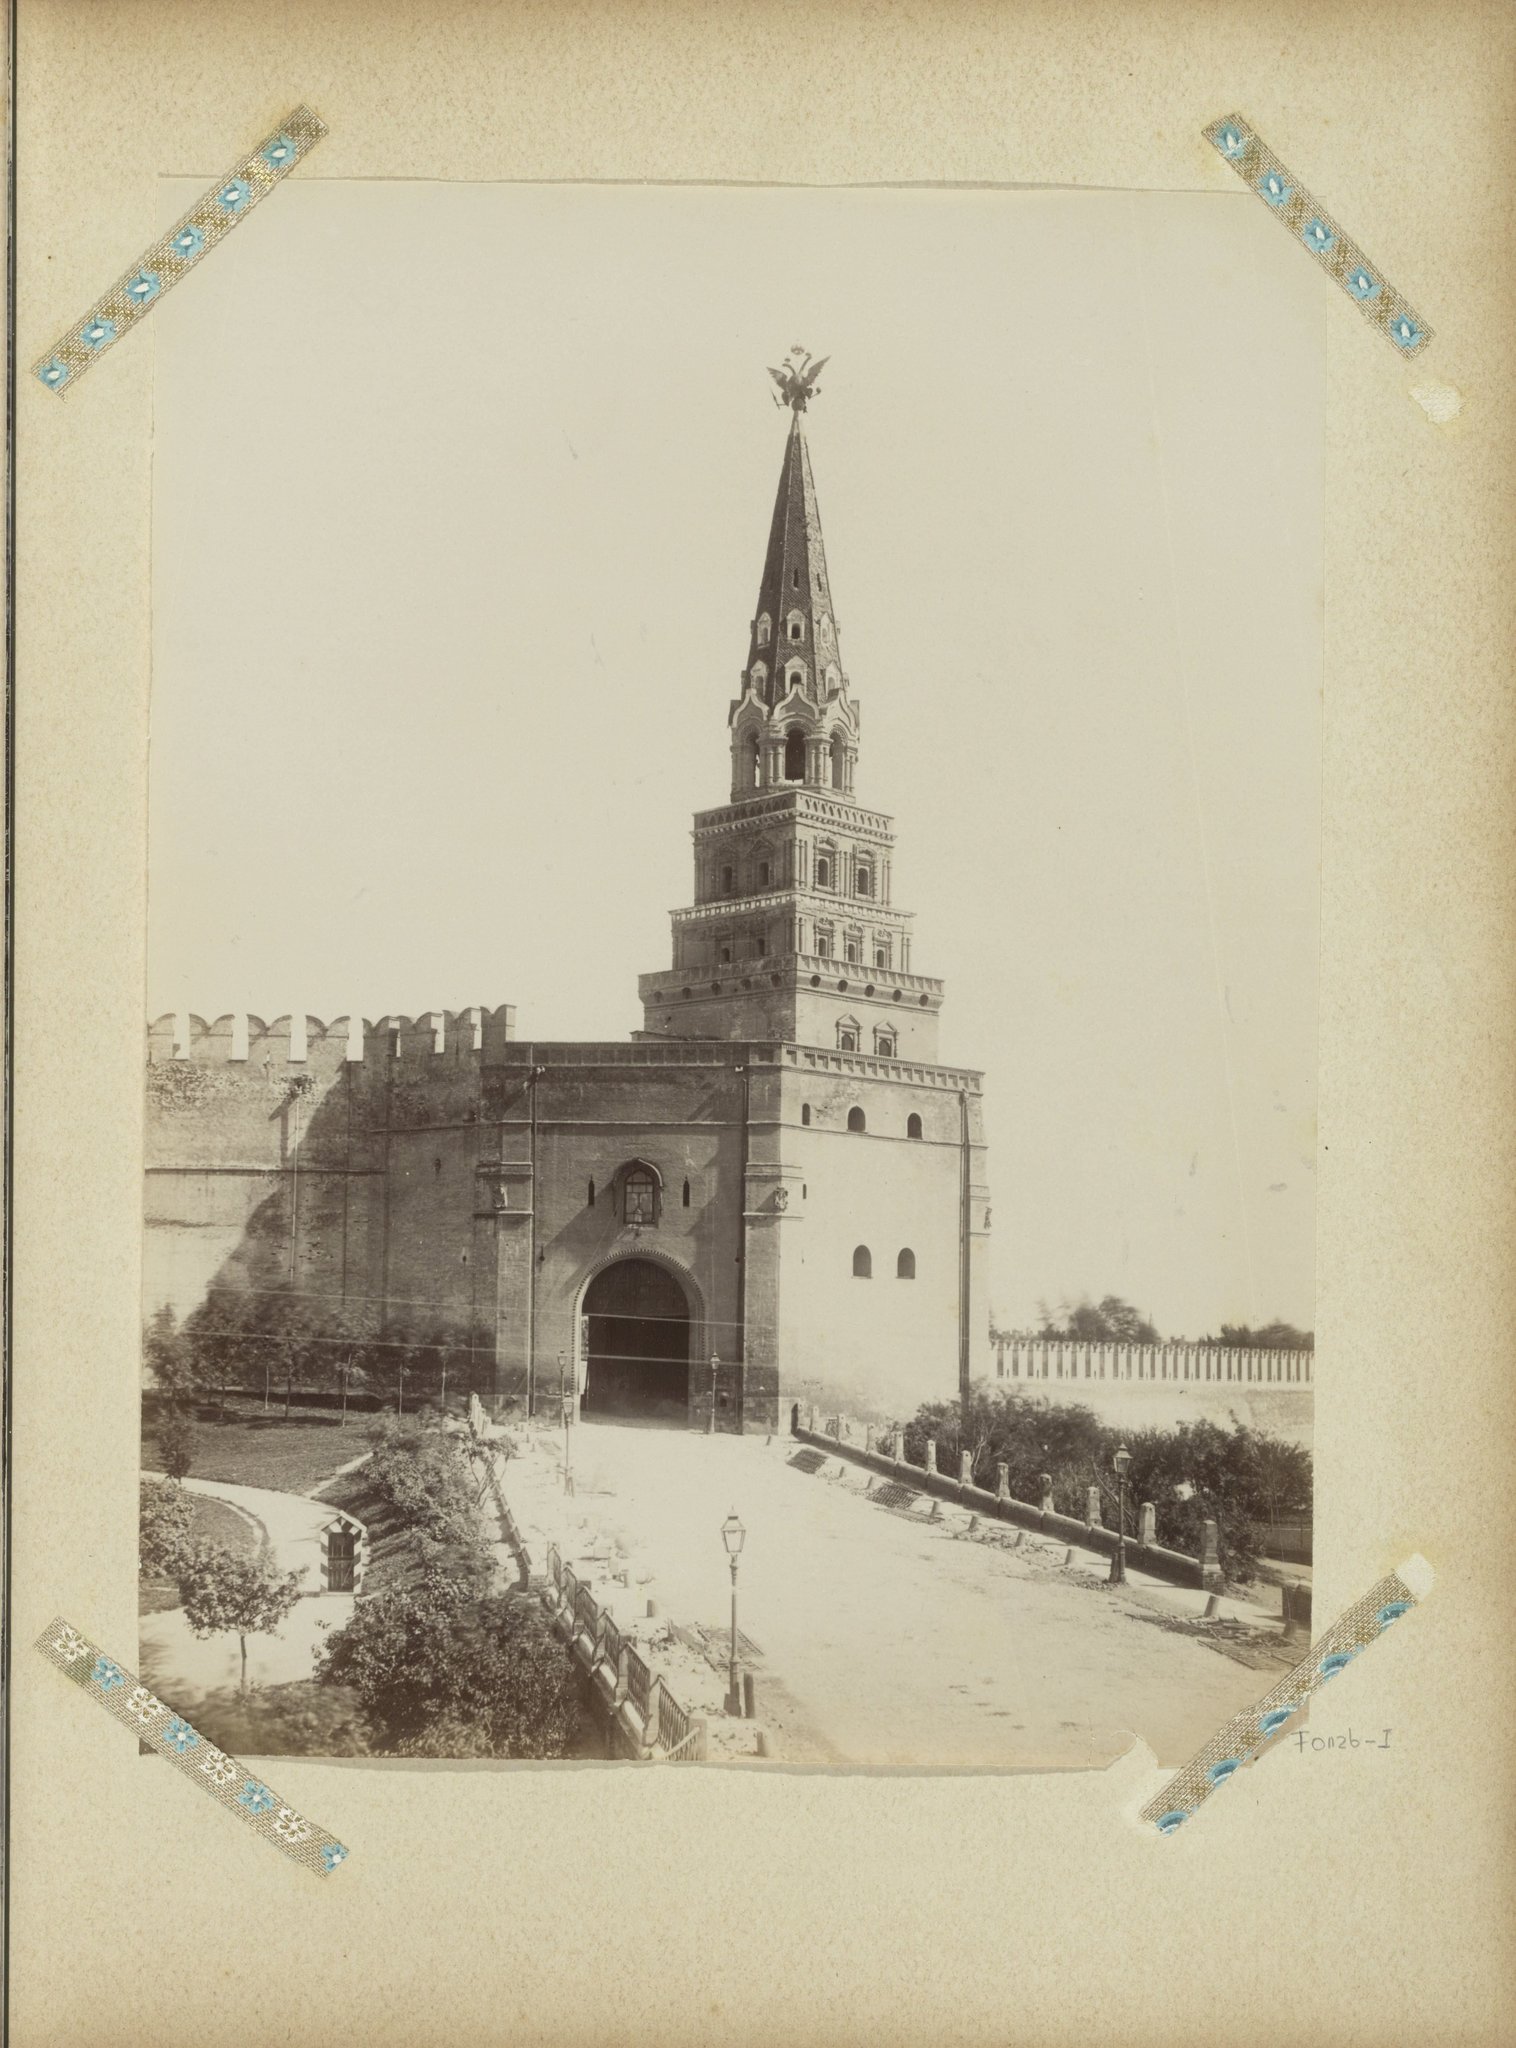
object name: photograph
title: Toren en poort bij het Kremlin in Moskou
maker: Anonymous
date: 1890-1900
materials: photographic support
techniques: albumen print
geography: moscow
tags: towers ~ fortified city, gate, entrance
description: Onderdeel van Fotoalbum met opnames van bezienswaardigheden in Georgië, Sint-Petersburg en Moskou.